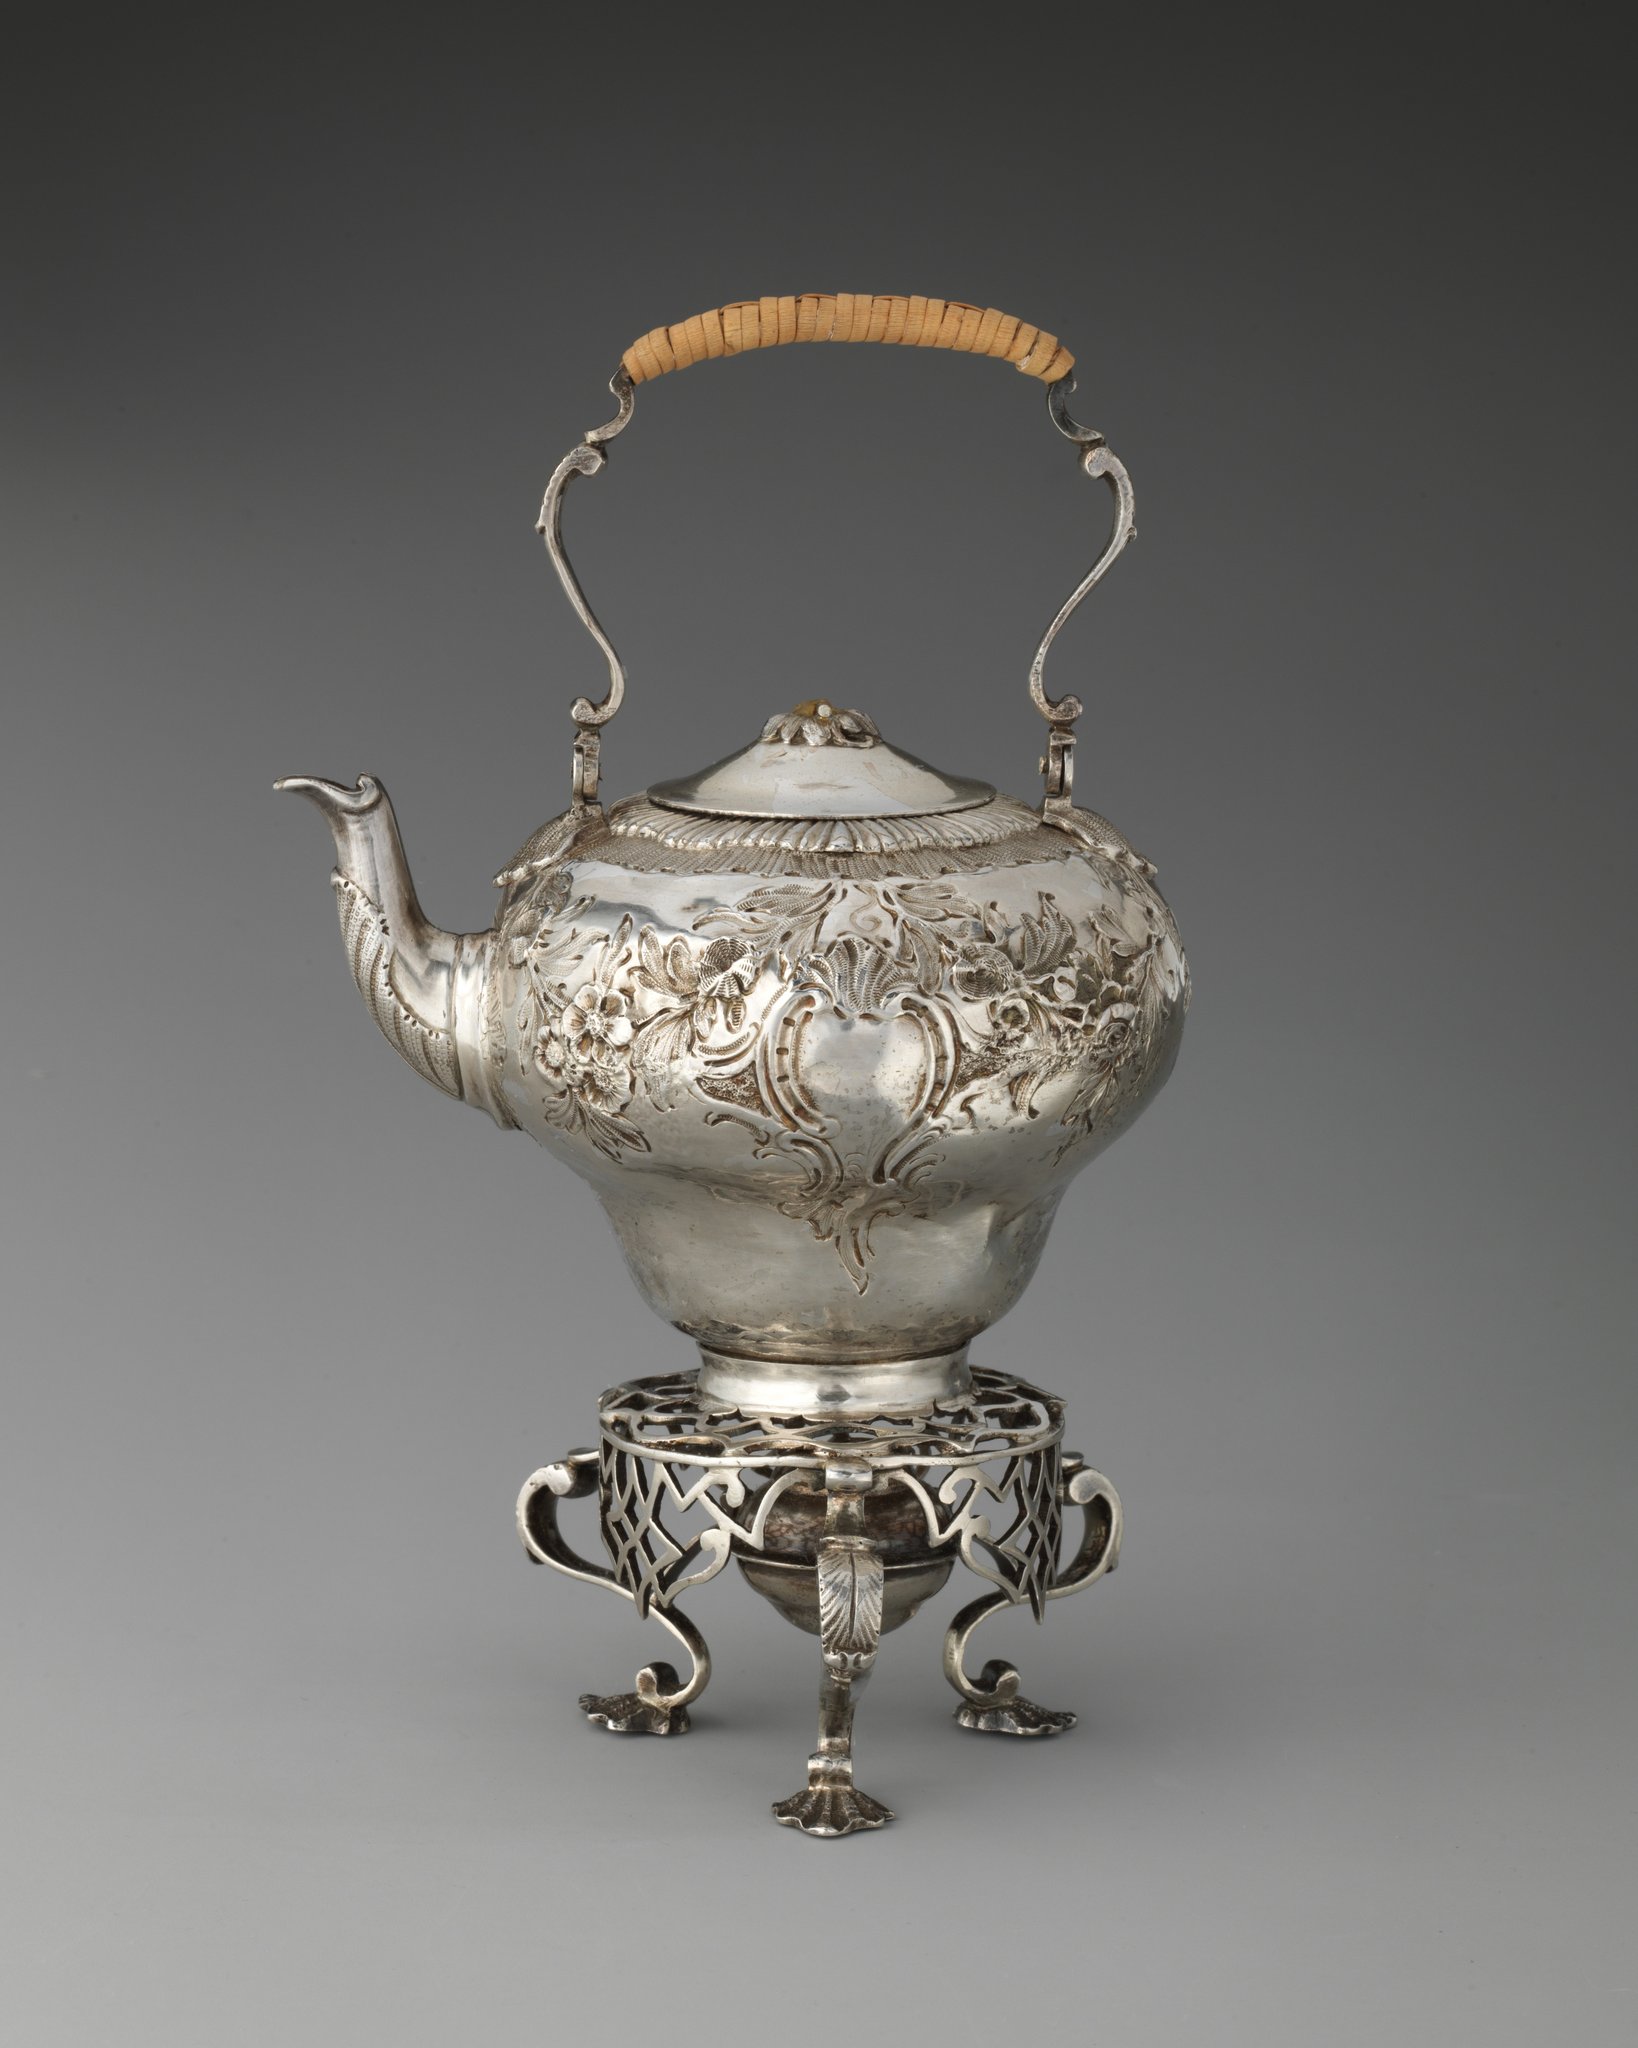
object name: kettle with stand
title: Miniature kettle with stand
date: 1701-1800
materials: silver